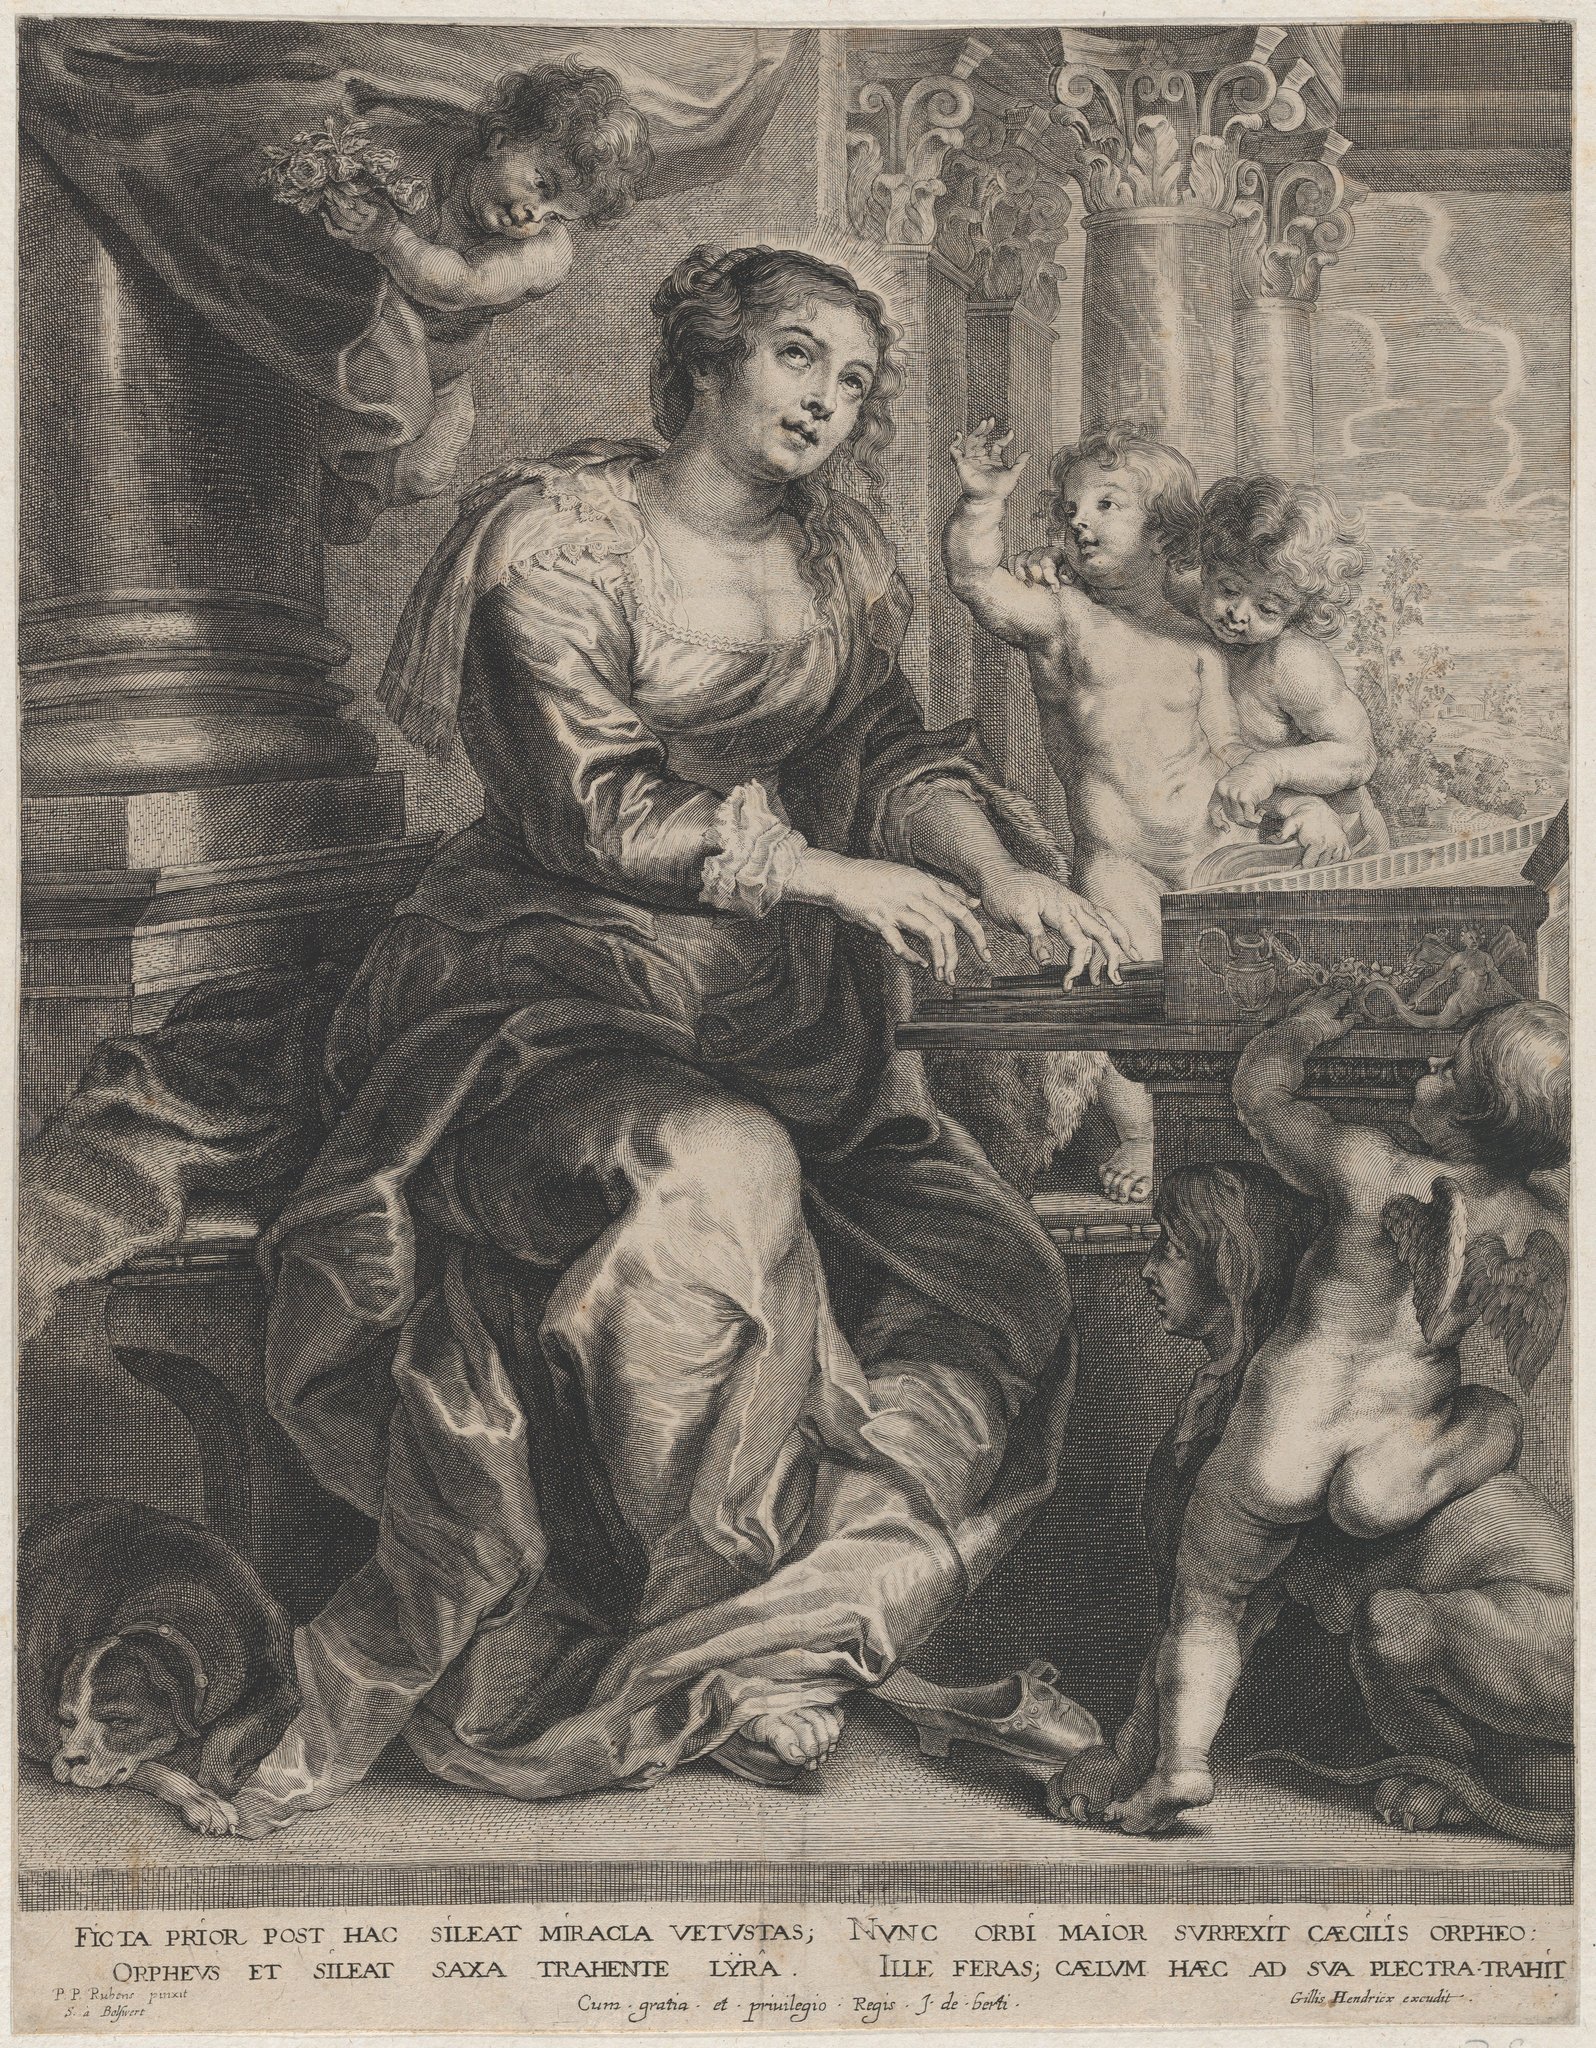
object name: print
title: Saint Cecilia playing the organ surrounded by putti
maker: schelte adams à bolswert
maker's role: artist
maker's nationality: dutch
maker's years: 1581-1659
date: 1640-1659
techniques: engraving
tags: organs,angels,saints